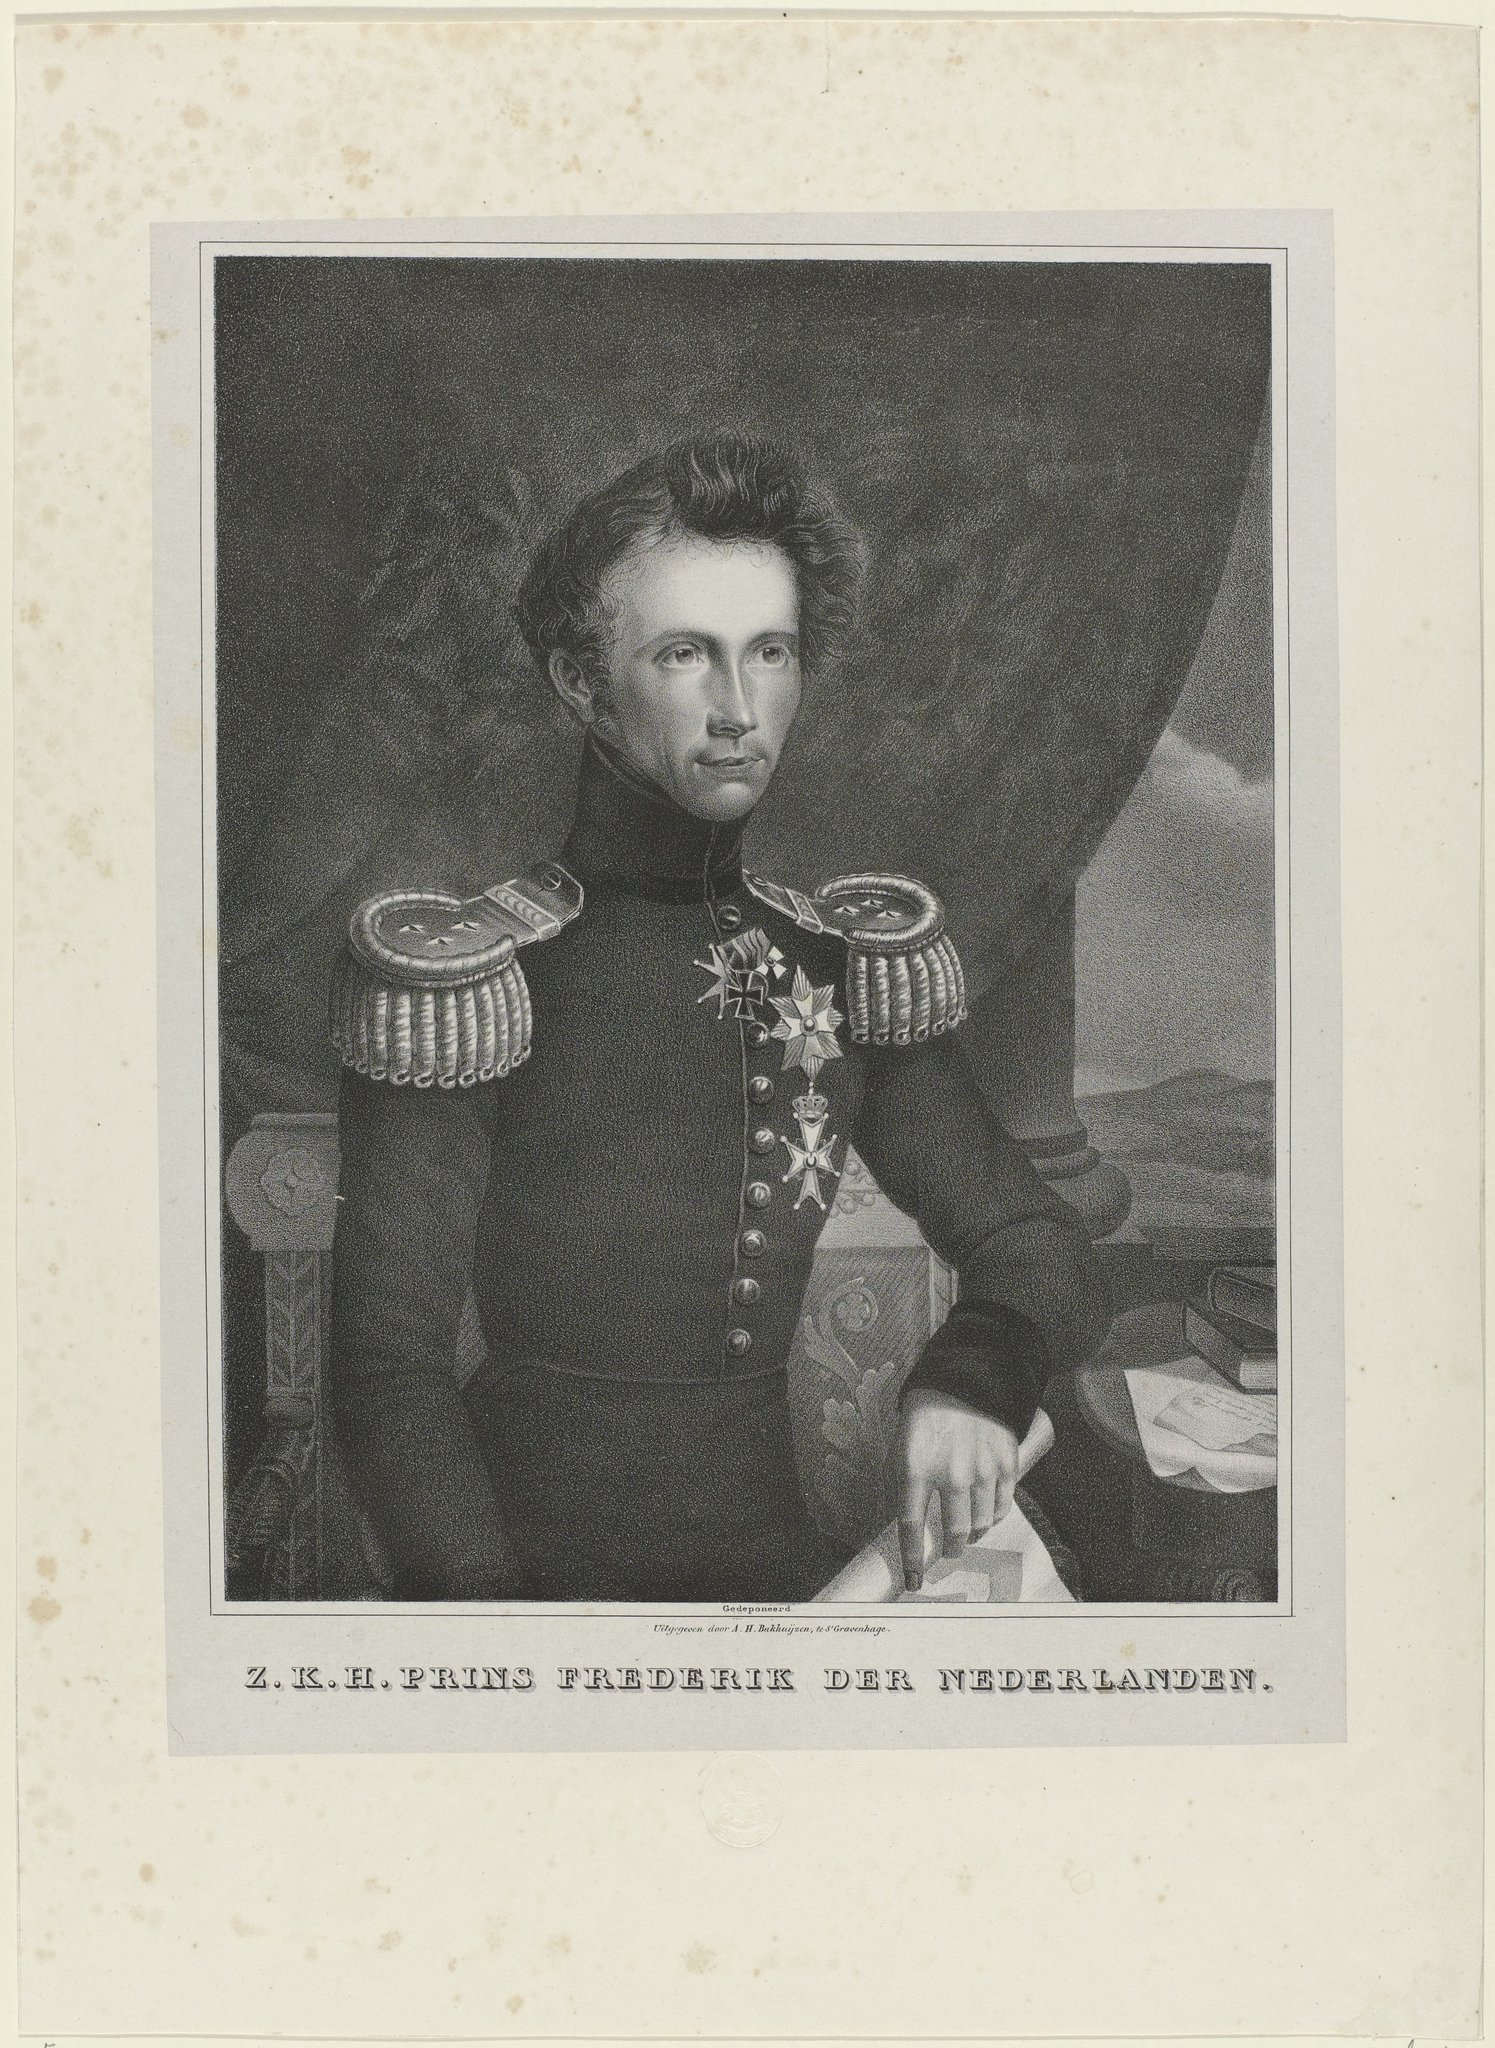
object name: print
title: Portret van Frederik, prins der Nederlanden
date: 1827-1871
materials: paper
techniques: lithograph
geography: the hague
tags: frederik (prins der nederlanden)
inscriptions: check stamp: ‘... HOF LEVERANCIER’, collector's mark: Lugt 963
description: De hier vermelde titel verwijst naar de hoogst verkregen titel van de geportretteerde, niet per se naar de titel die de geportretteerde op deze voorstelling draagt.